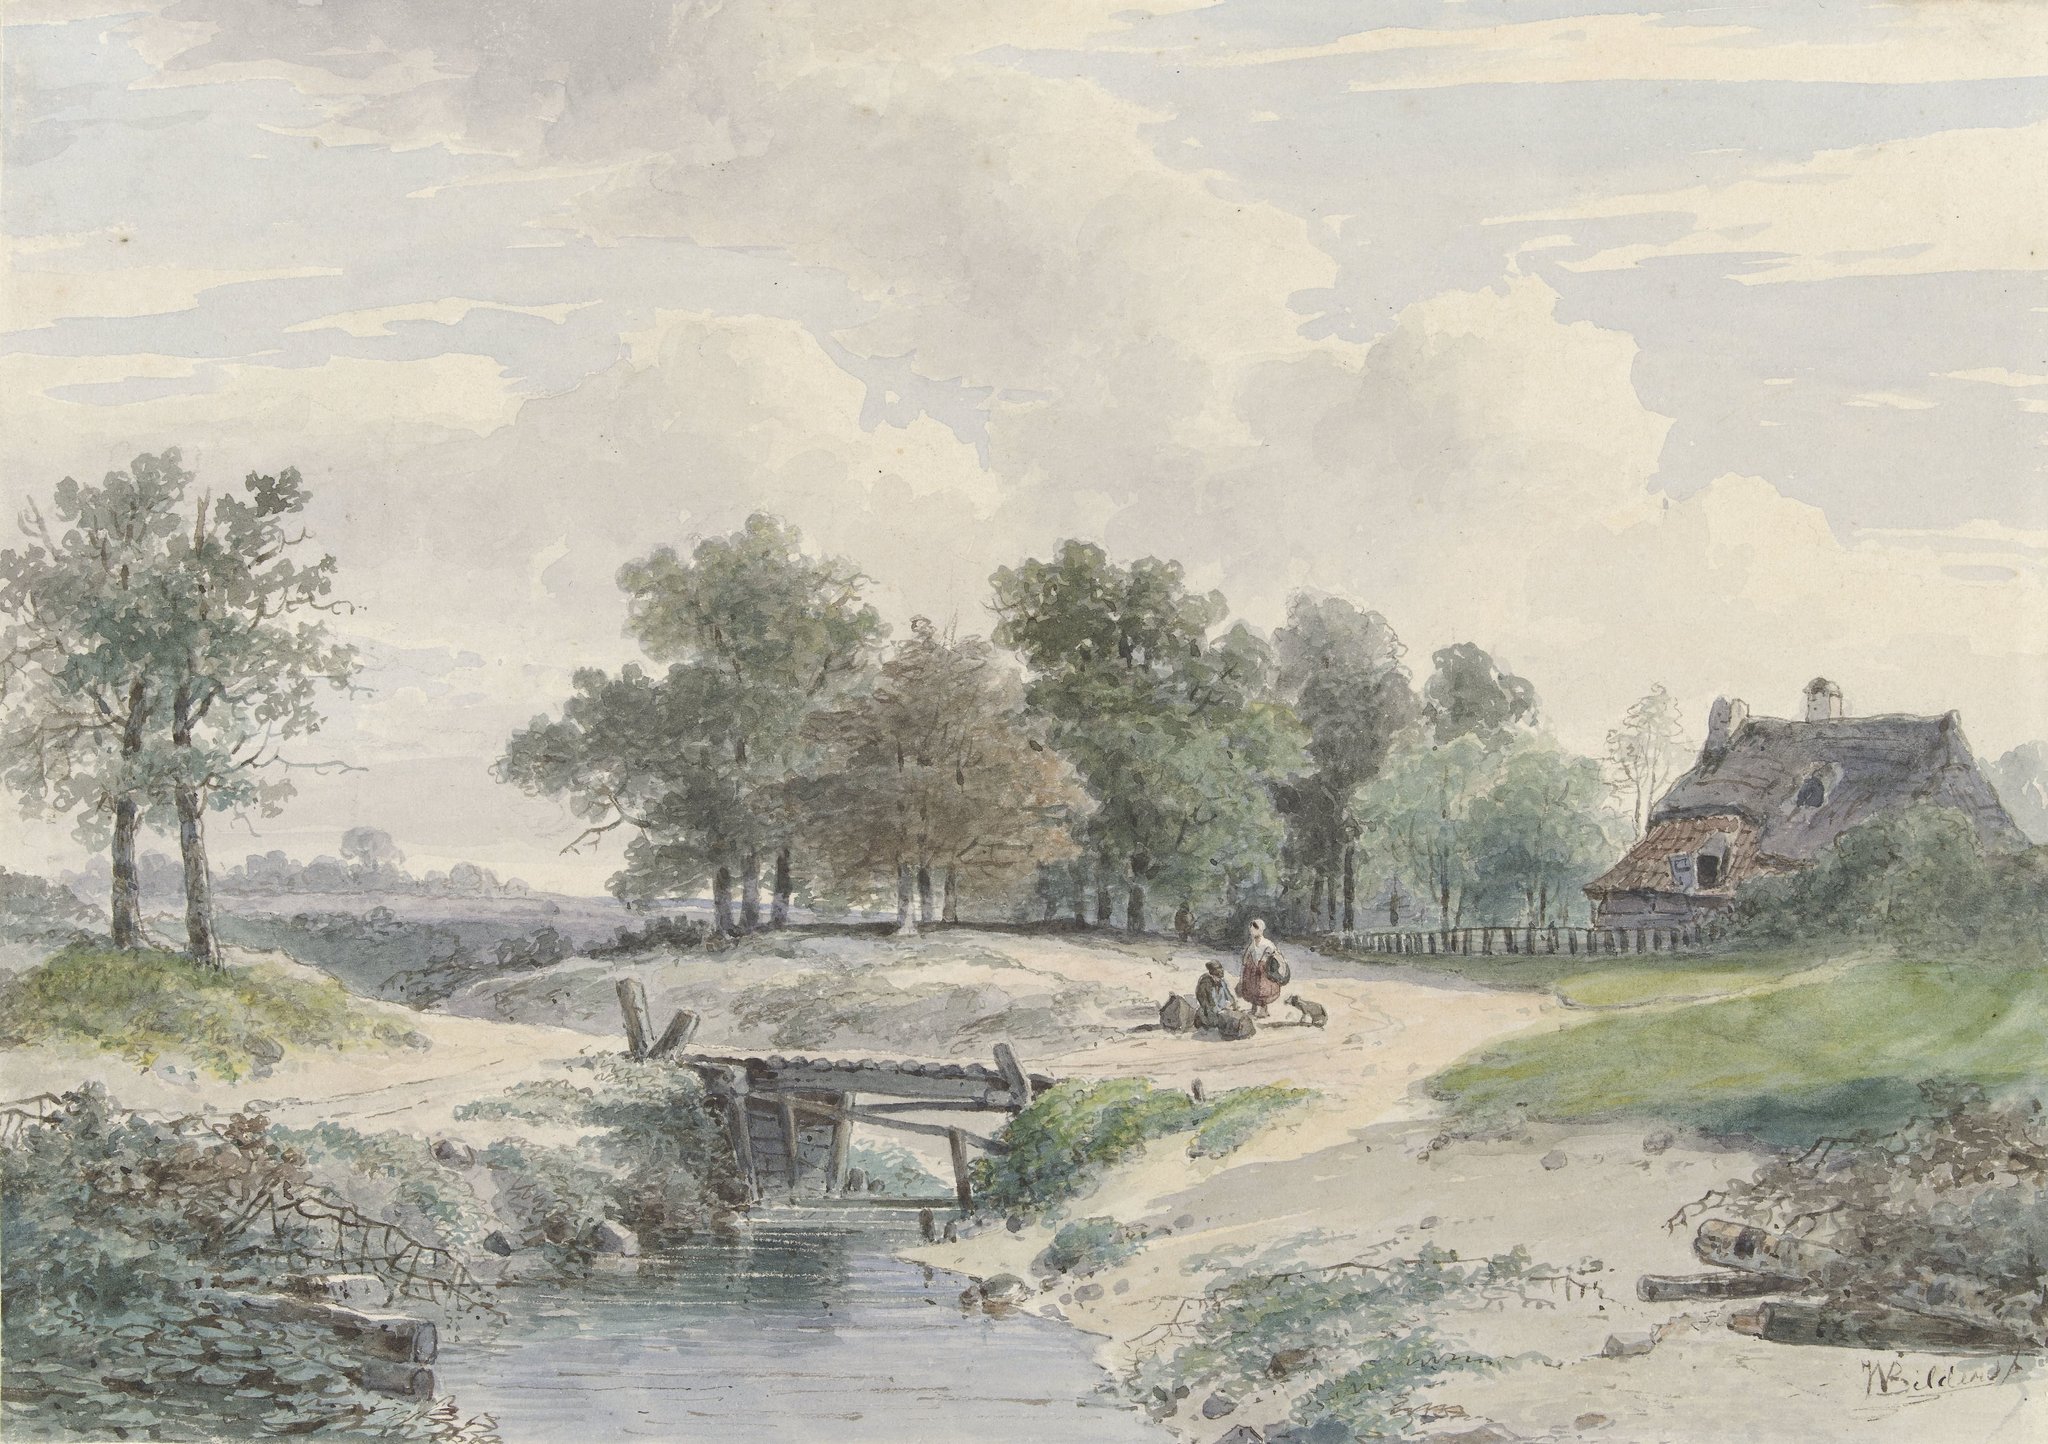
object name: watercolor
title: Landschap met bruggetje en figuren voor een boerderij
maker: johannes warnardus bilders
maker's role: painter, print maker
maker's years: 1811-1890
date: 1841-1890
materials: ink, paper, watercolor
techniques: brush, pen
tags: farm or solitary house in landscape